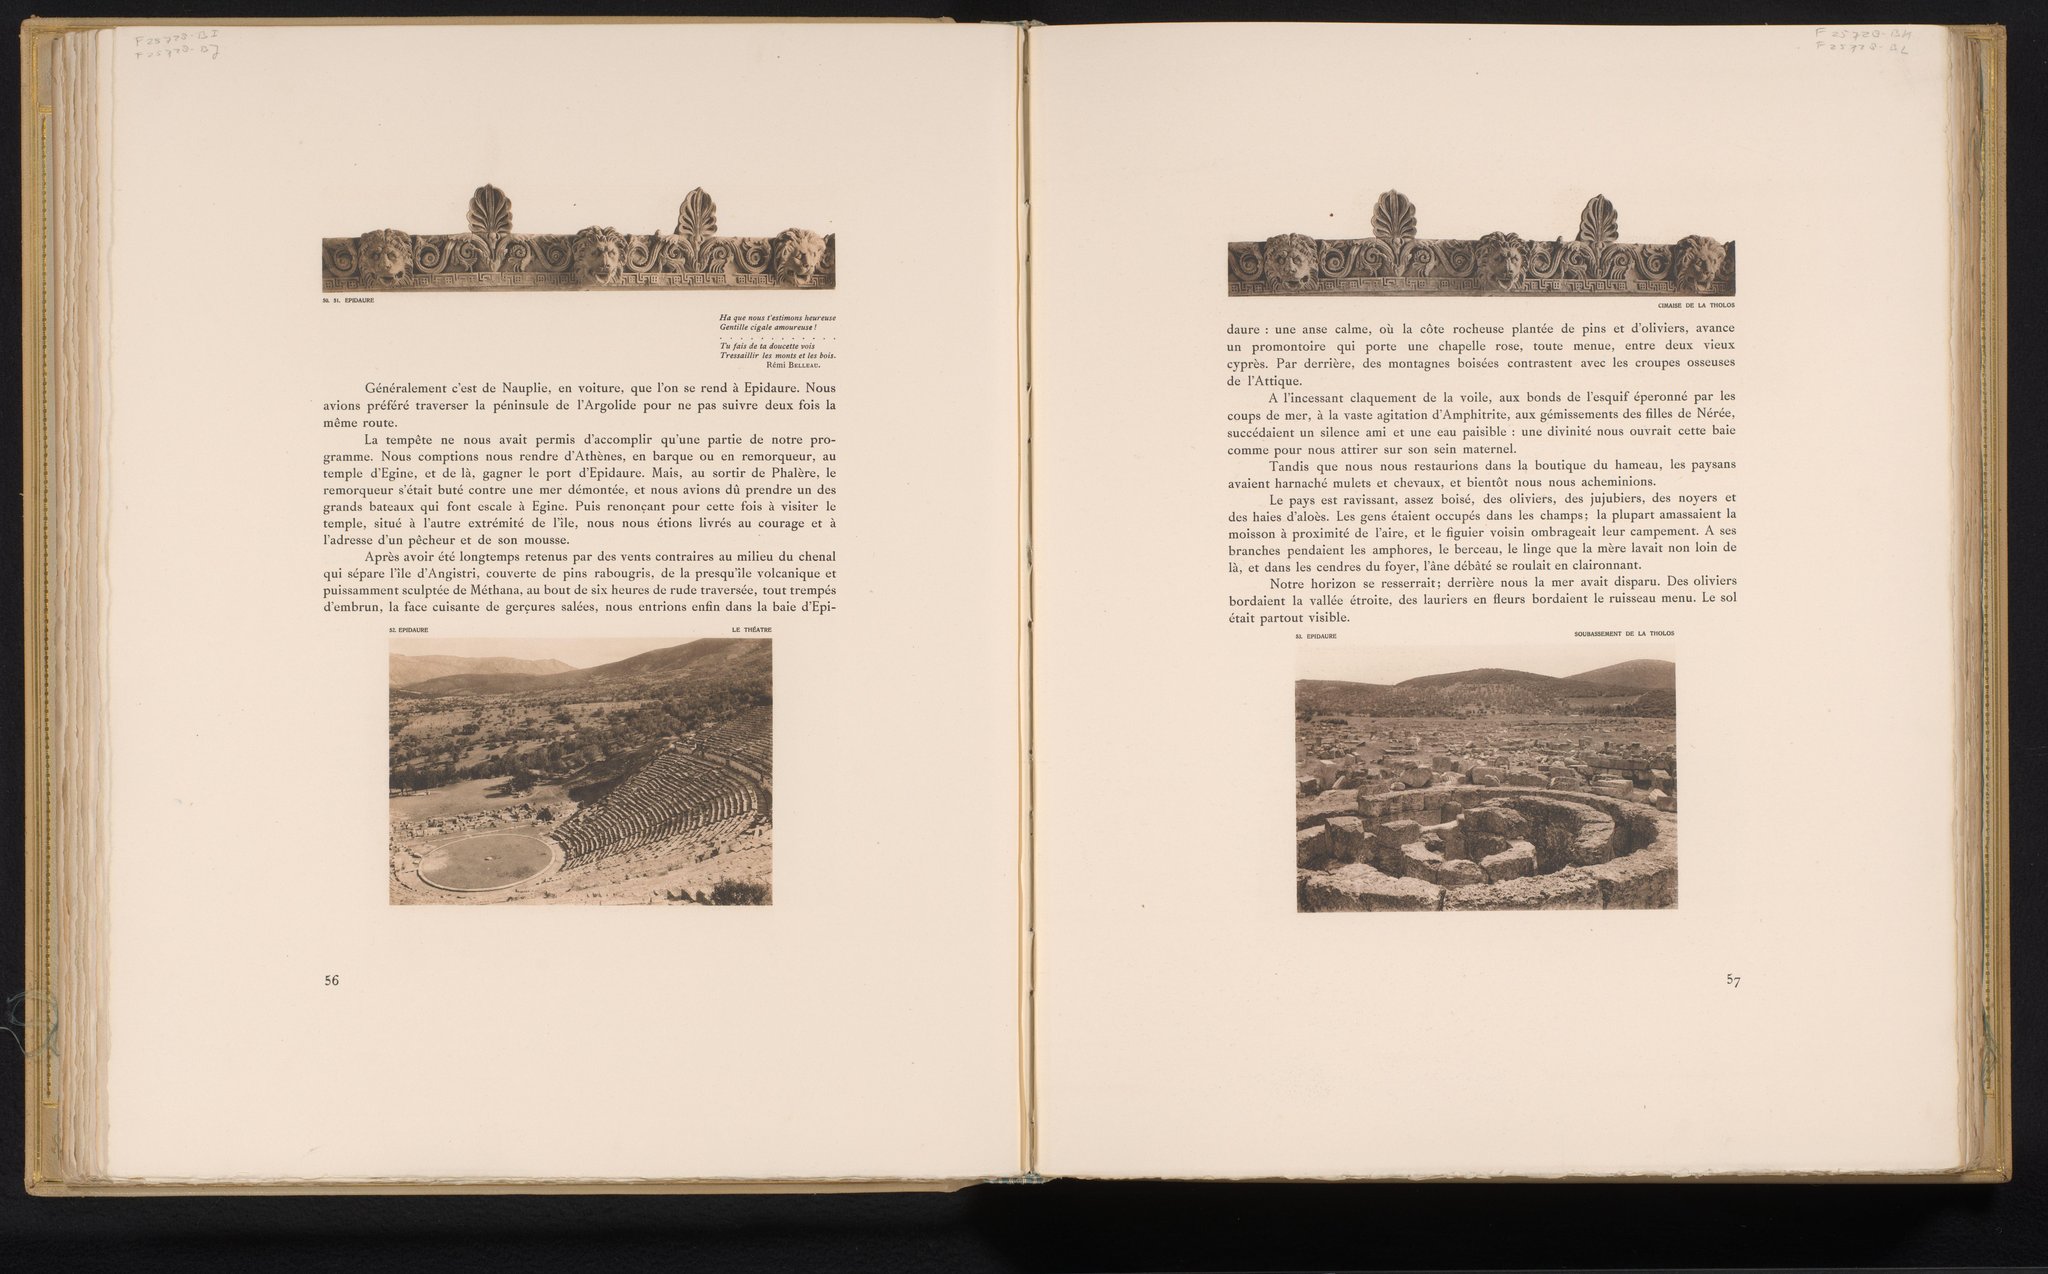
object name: page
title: Epidaure, soubassement de la tholos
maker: frédéric boissonnas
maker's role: fotograaf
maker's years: 1858-1946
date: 1905-1910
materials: paper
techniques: photograph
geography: epidaurus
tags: landscape with ruins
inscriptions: number: ‘53.’